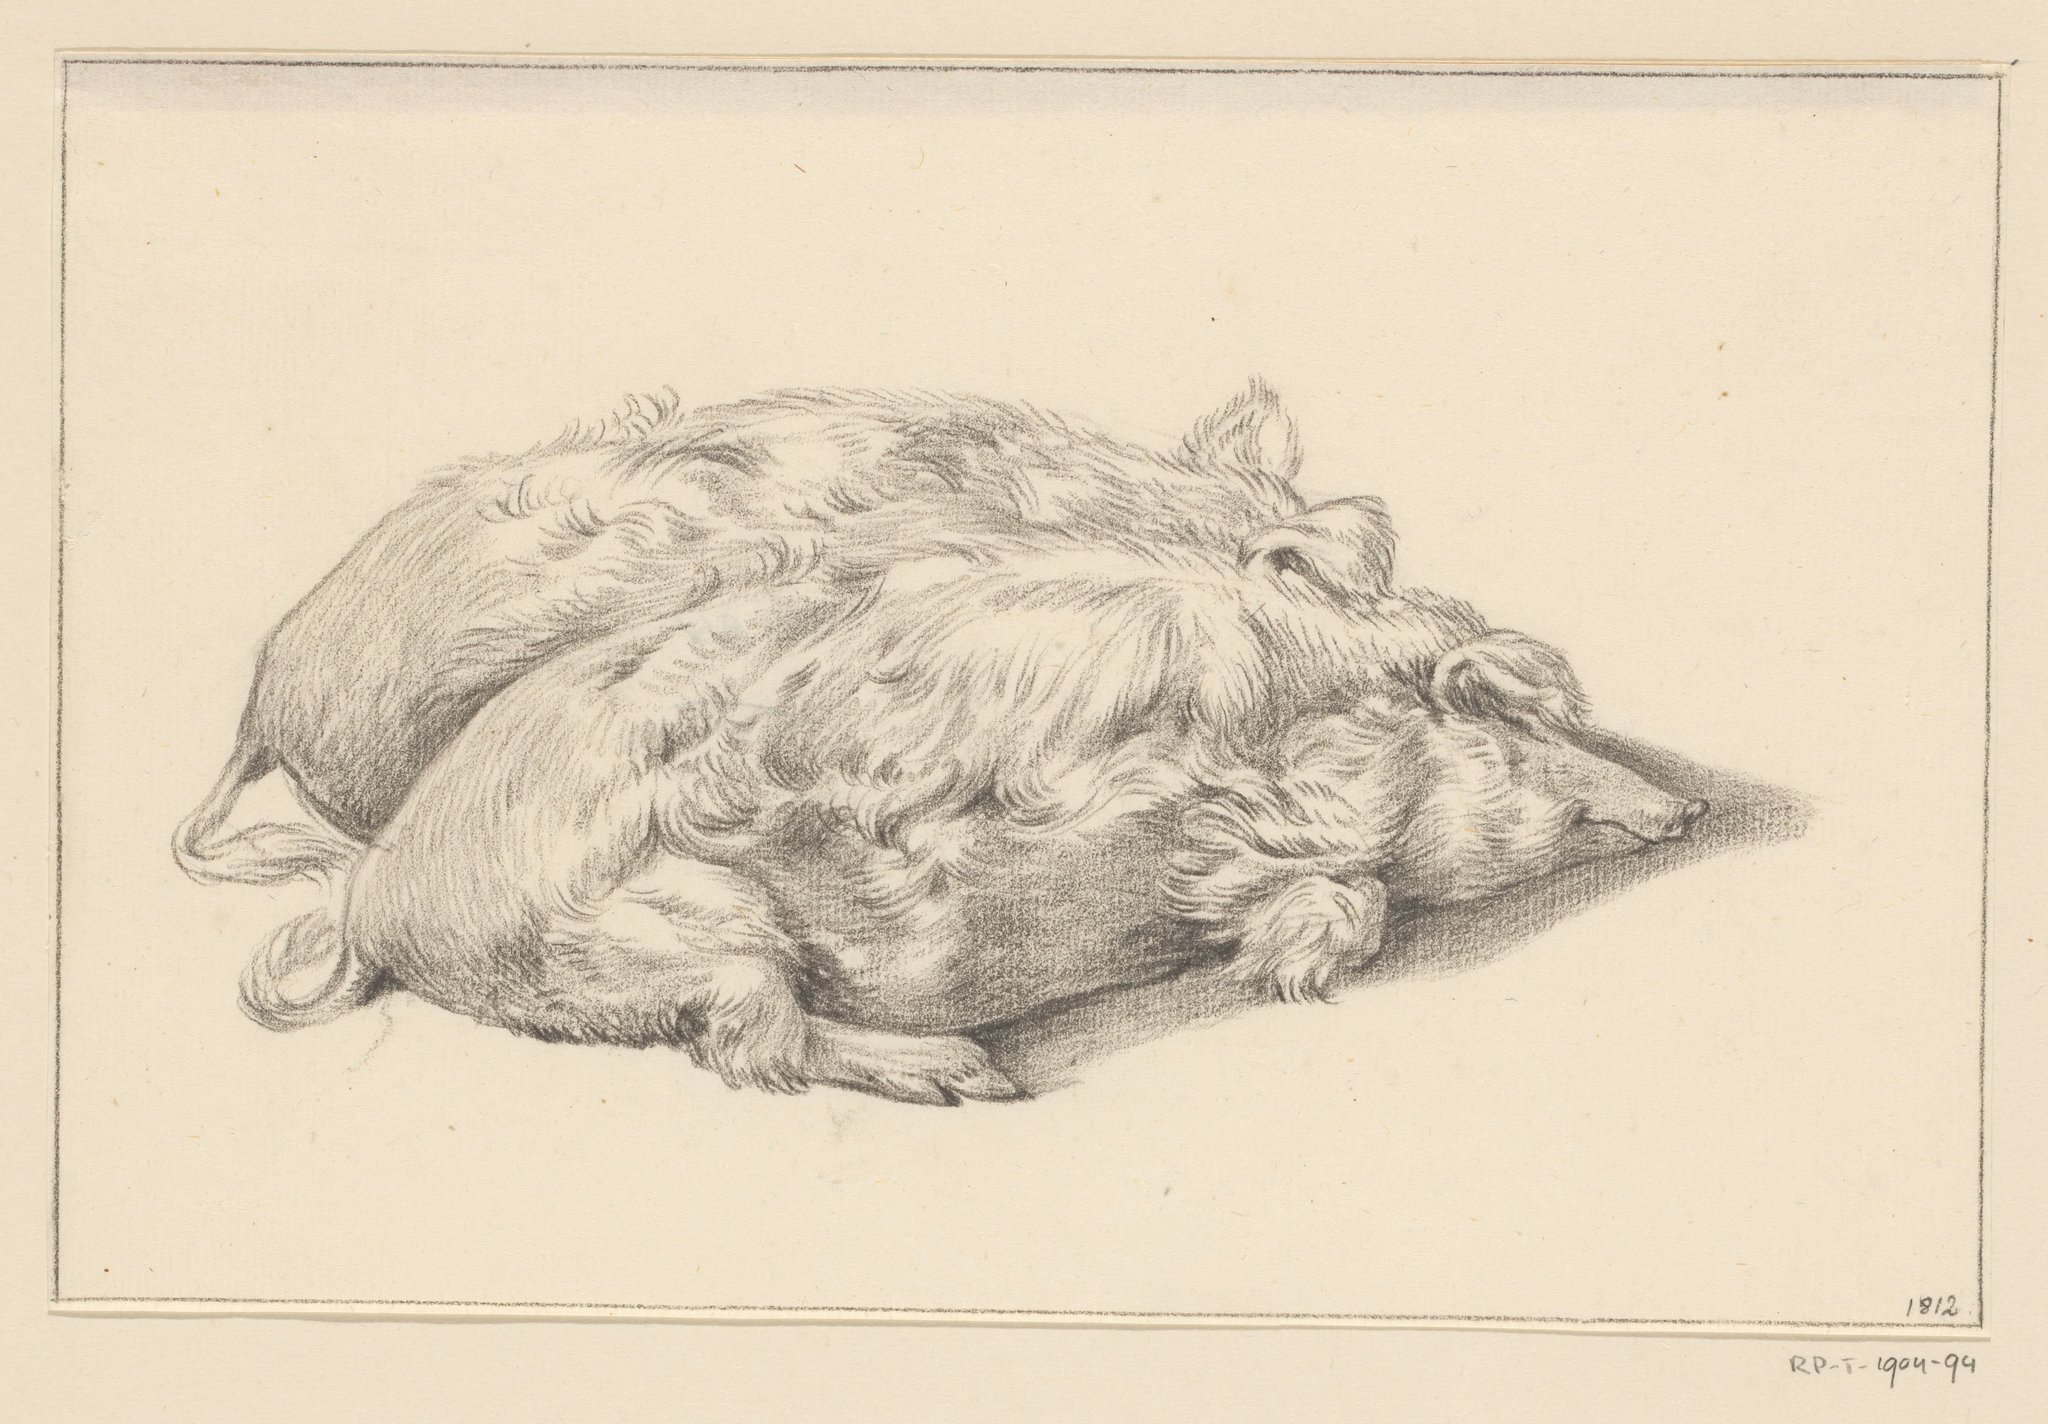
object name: drawing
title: Twee naast elkaar liggende varkens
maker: jean bernard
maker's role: draughtsman, print maker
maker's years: 1765-1833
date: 1812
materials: chalk, paper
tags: pig